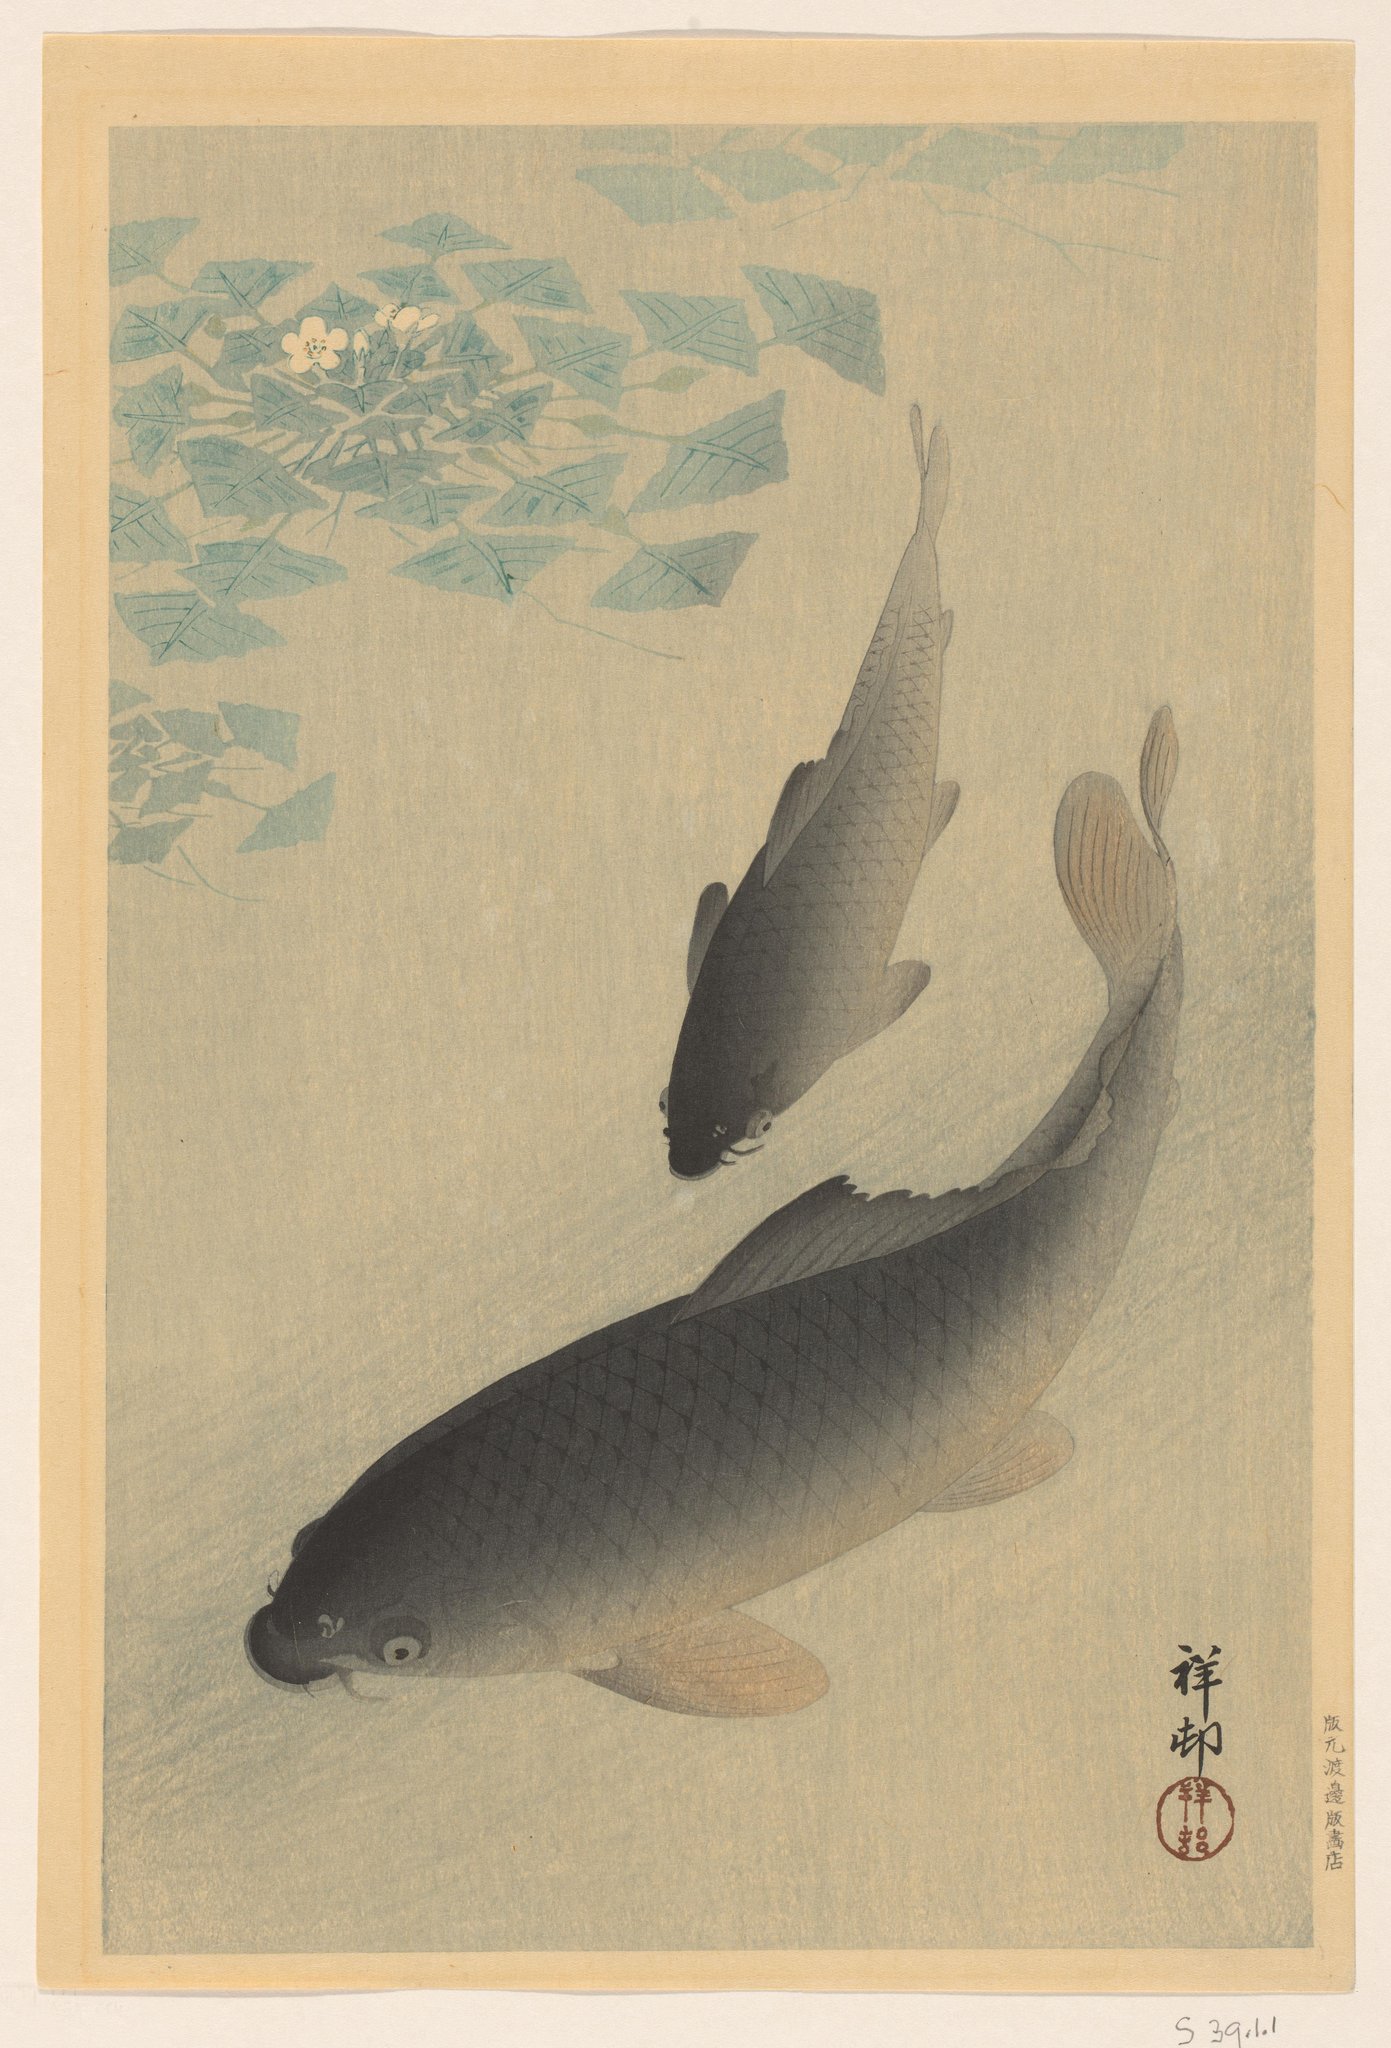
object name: print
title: Twee karpers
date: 1926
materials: paper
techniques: woodcut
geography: japan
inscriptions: collector's mark: Lugt 2228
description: Twee karpers in het water, bij bloeiende waterplanten.